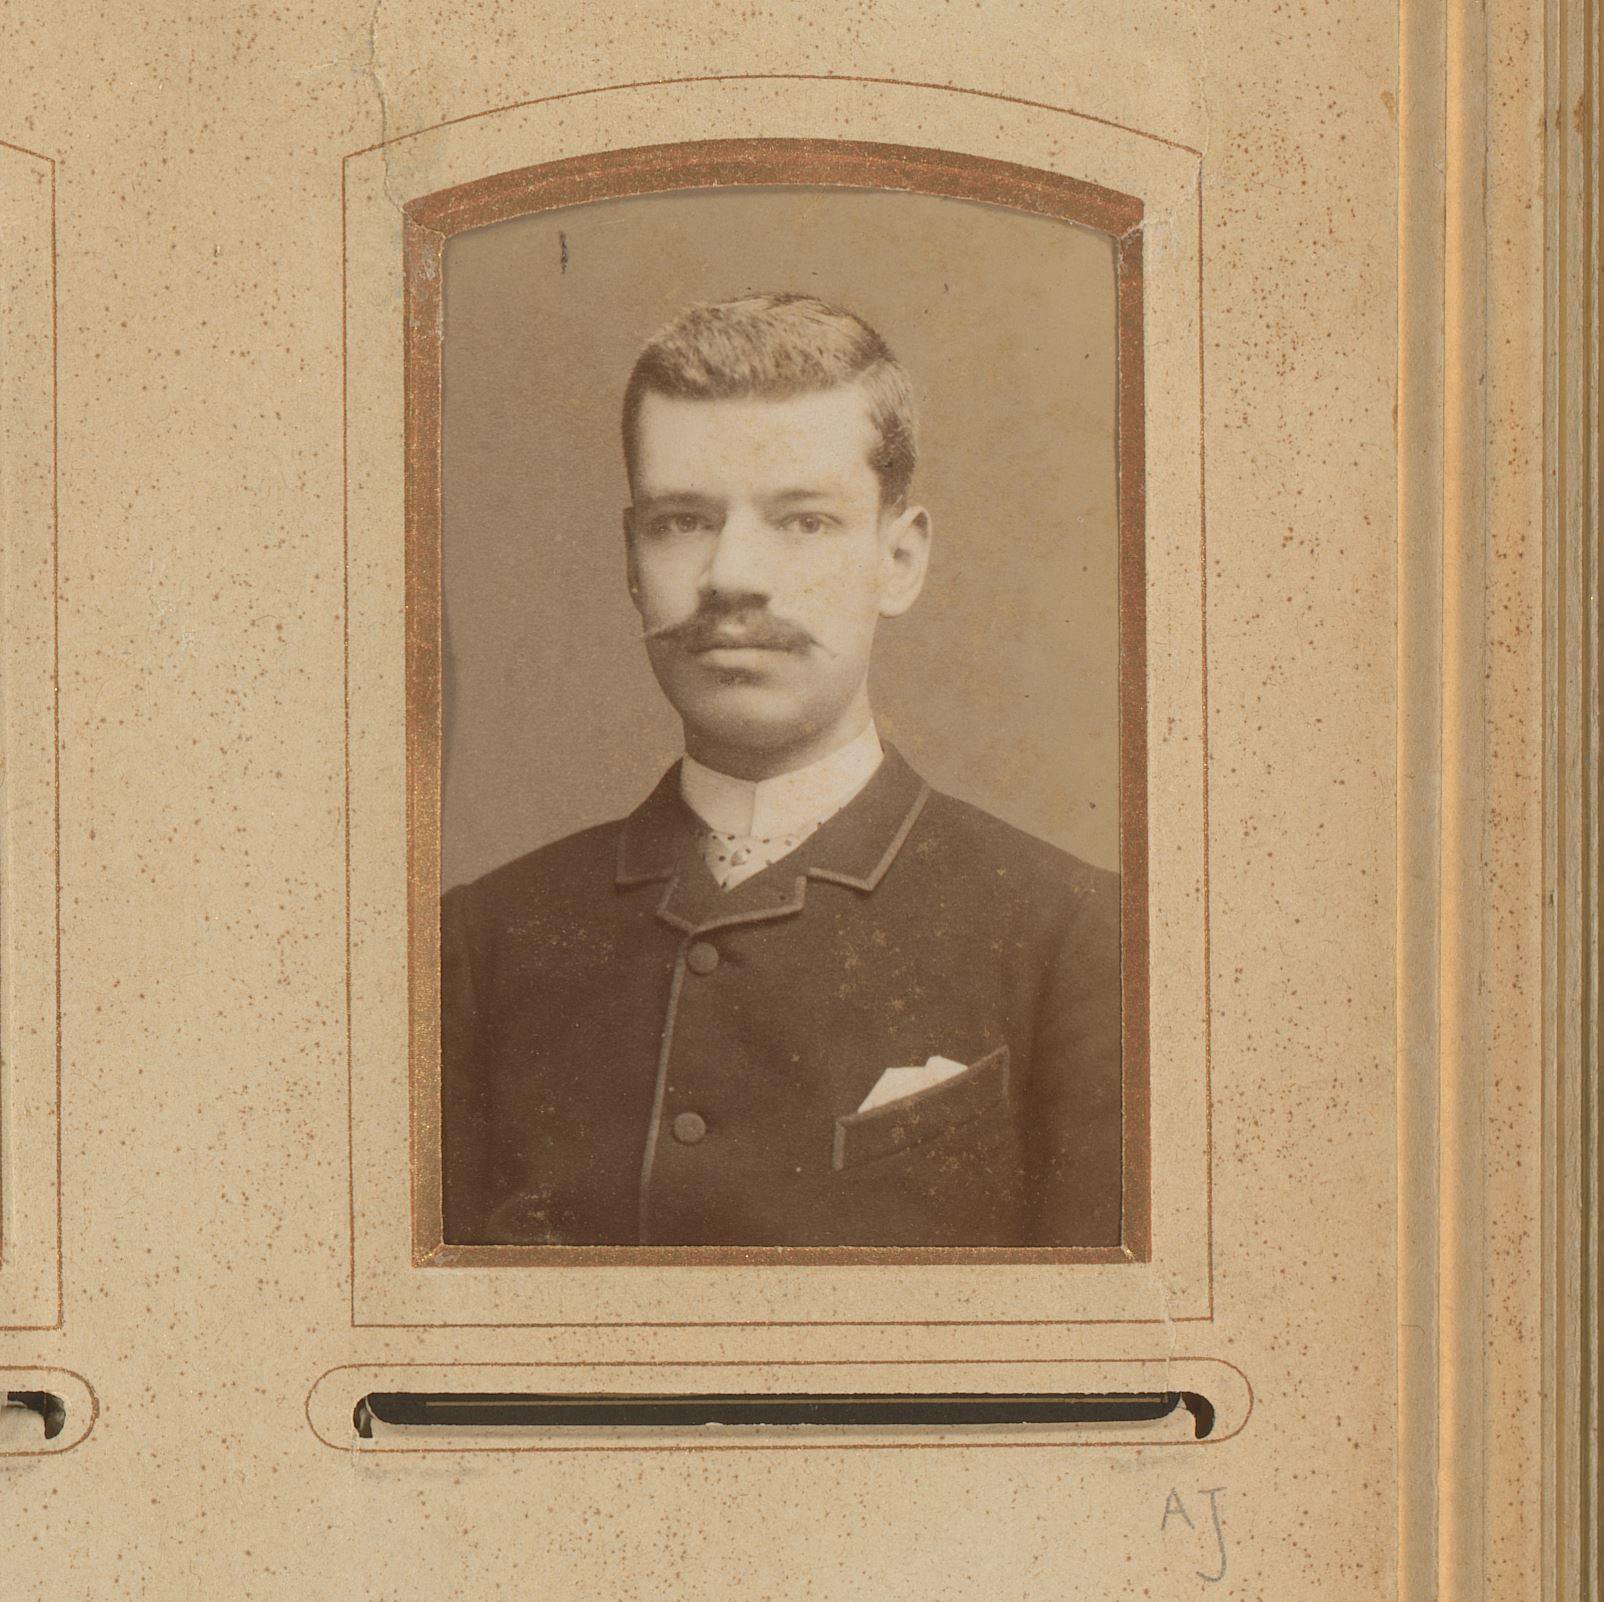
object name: carte de visite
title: Portret van een man met snor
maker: johannes hendrikus kramer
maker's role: fotograaf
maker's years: 1846-1901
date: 1863-1901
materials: cardboard, photographic support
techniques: albumen print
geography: utrecht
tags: moustache, historical persons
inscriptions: inscription: ‘Photographisch/ Atelier/ van/ Johs. H. Kramer/ Vrouwjuttenstraat A.344,/ Oude gracht b/d Geertebrug./ UTRECHT./ De platen blijven ter nabestelling bewaard./ Inrichting voor vergrootingen.’